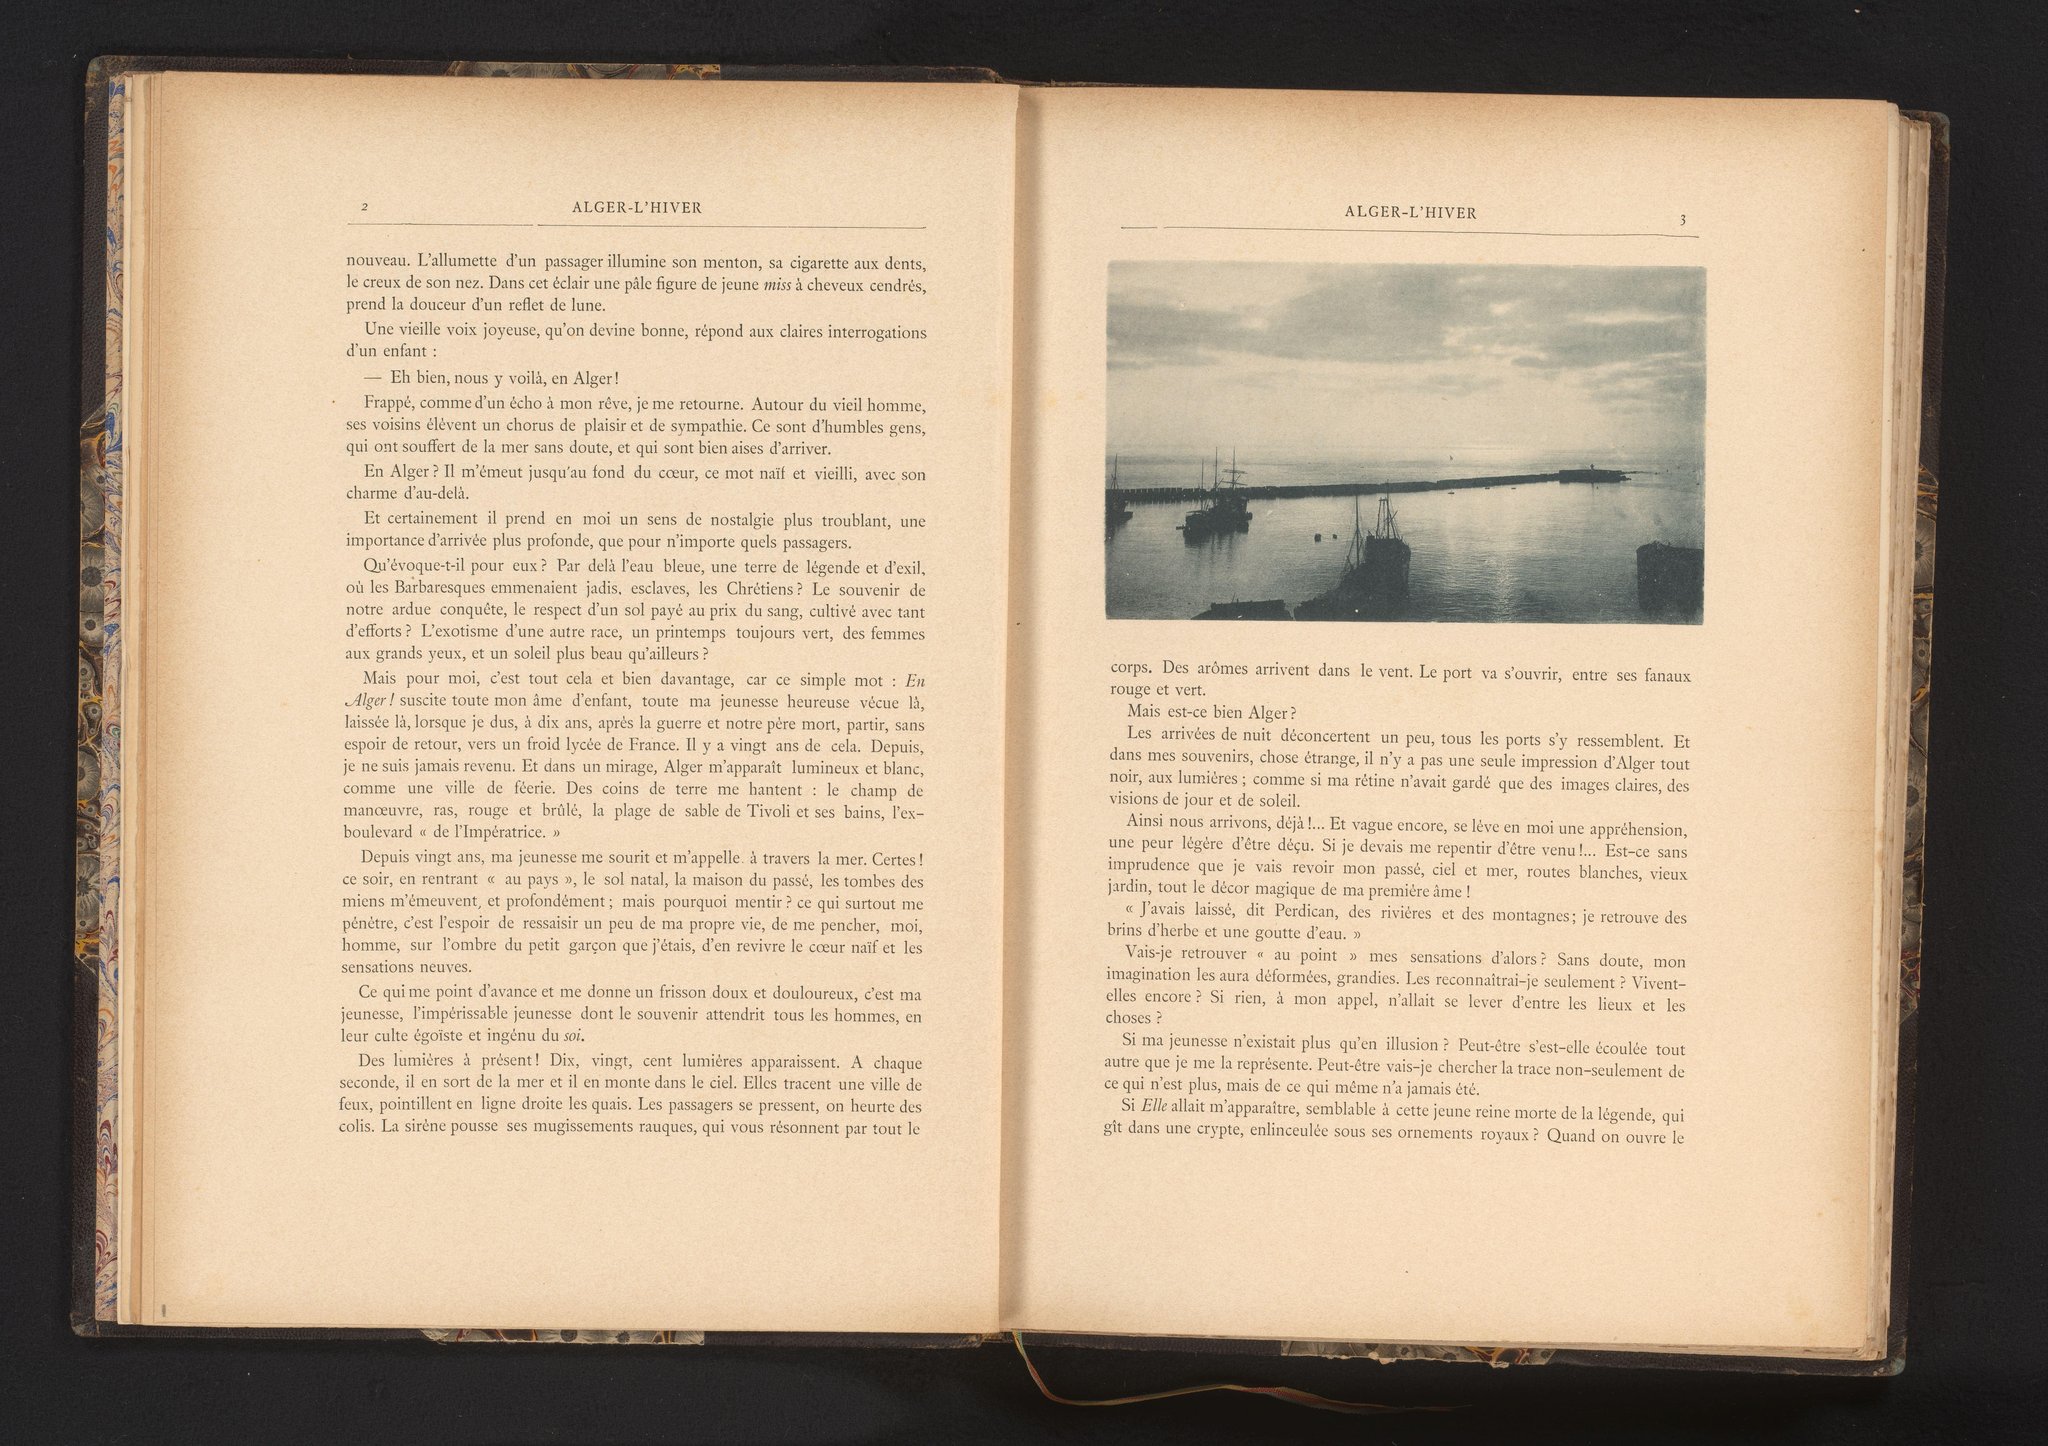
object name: page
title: Gezicht op de haven van Algiers, Algerije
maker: jules gervais-courtellemont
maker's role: fotograaf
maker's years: 1863-1931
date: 1888-1893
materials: paper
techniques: photograph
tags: harbour